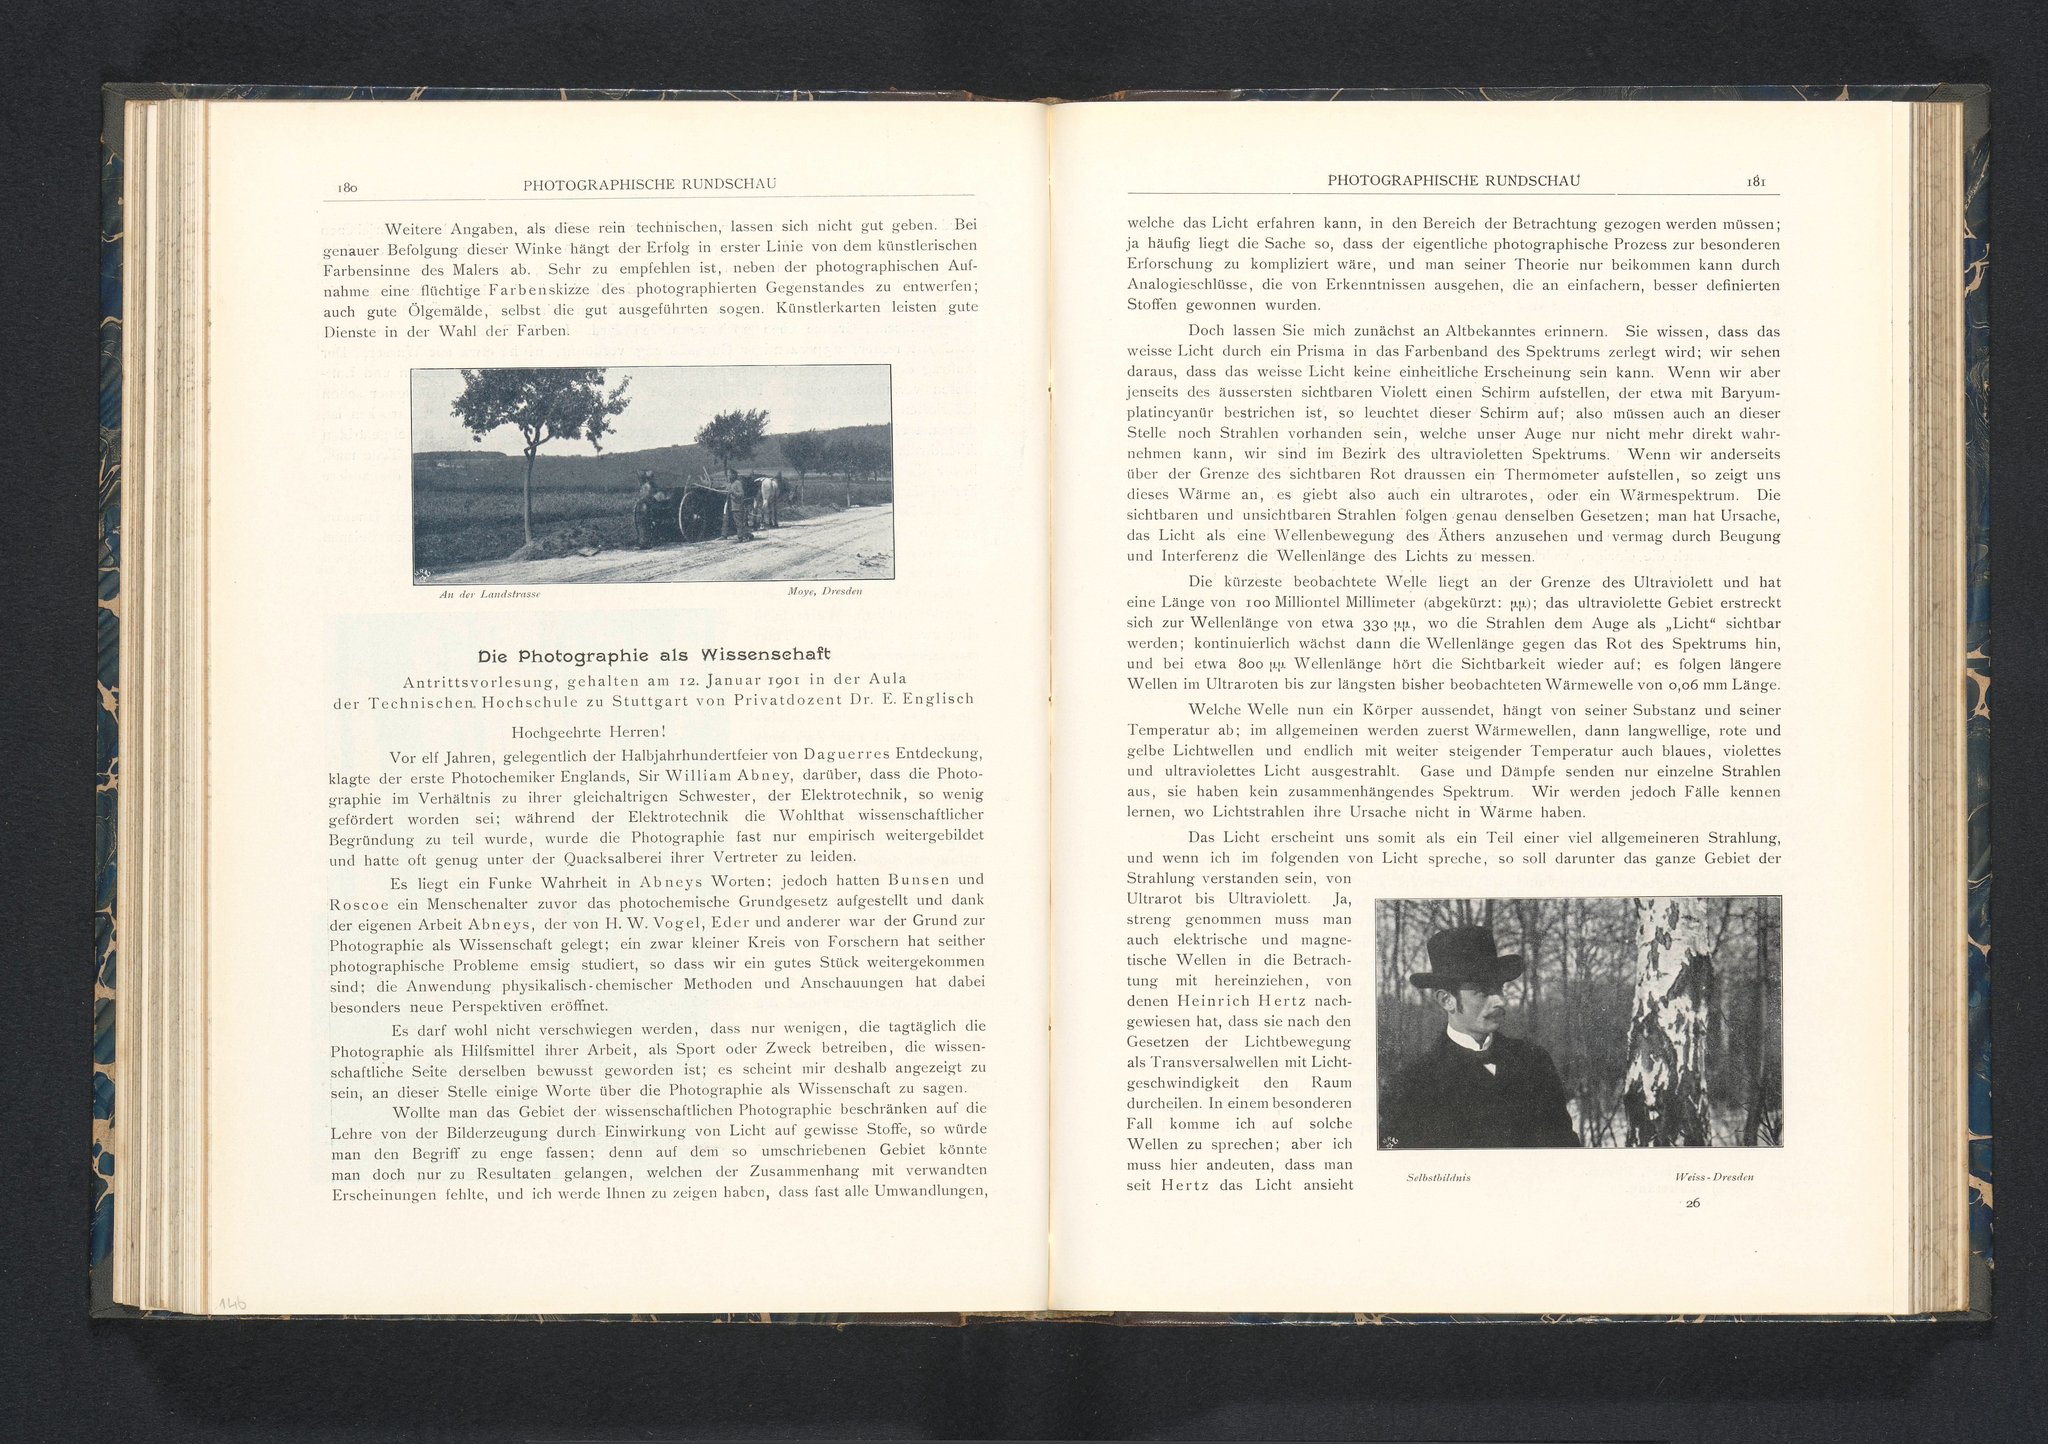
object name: page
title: Man met paard en wagen aan een landweg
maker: moye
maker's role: fotograaf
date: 1896-1901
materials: paper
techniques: autotype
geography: berlin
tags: adult man, road, path, (farm) wagon, freight wagon, cart